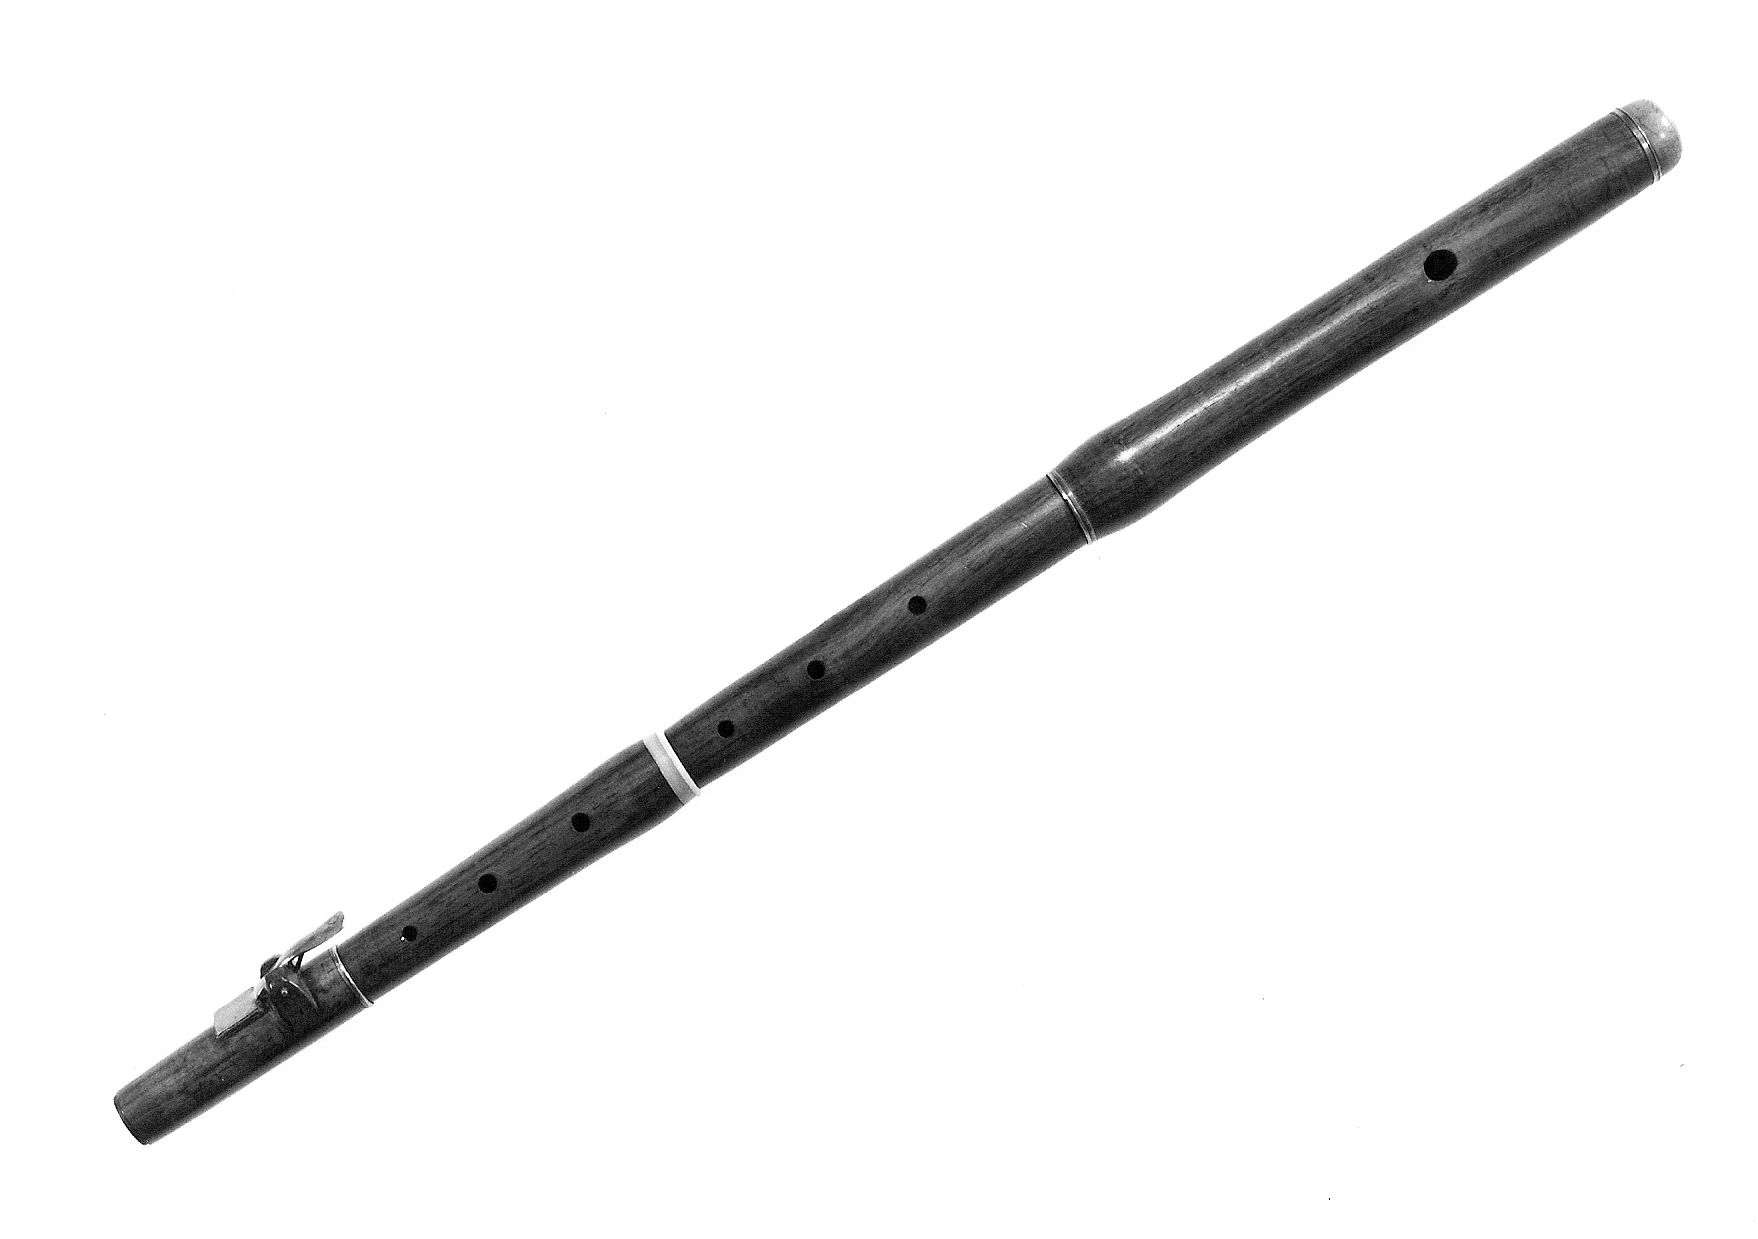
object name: transverse flute in e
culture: german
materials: brass, horn, wood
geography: germany